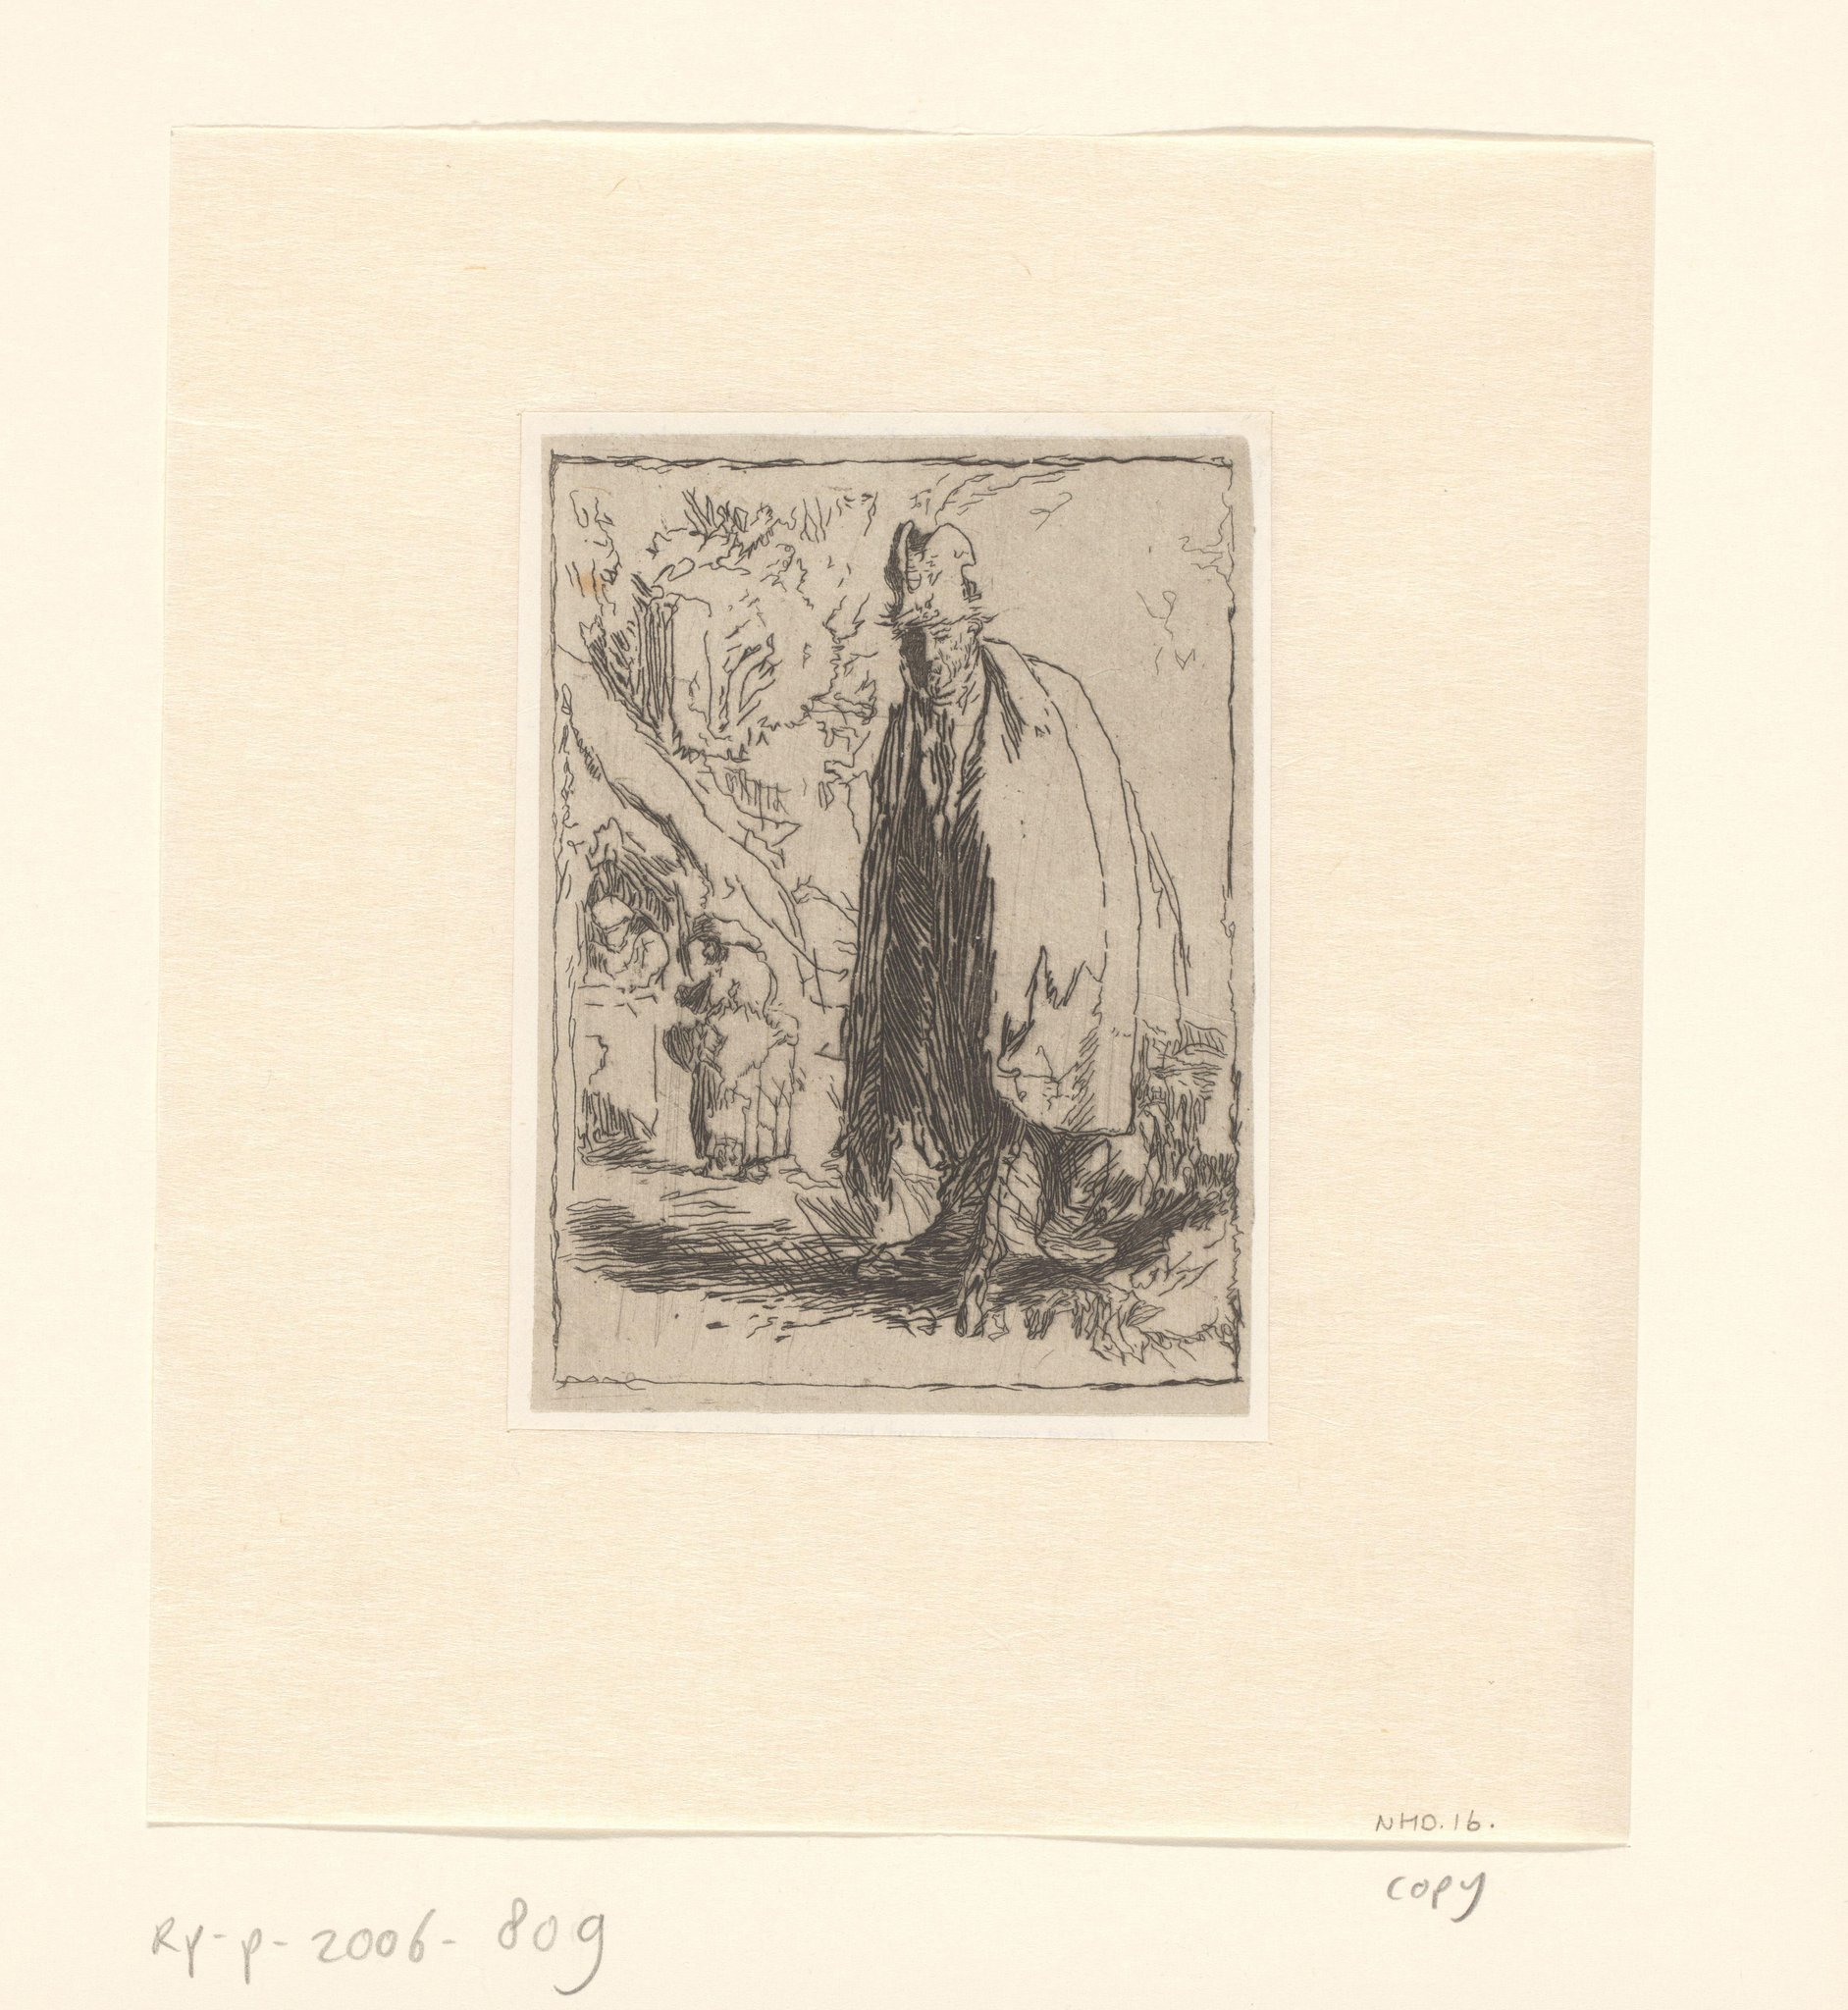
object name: print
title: A beggar in a tall hat and long cloack, with a cottage and two figures in the background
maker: léopold flameng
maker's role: print maker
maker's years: 1831-1911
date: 1859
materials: paper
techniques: etching, intaglio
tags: beggar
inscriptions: collector's mark: Lugt 2760, collector's mark: Lugt 2228